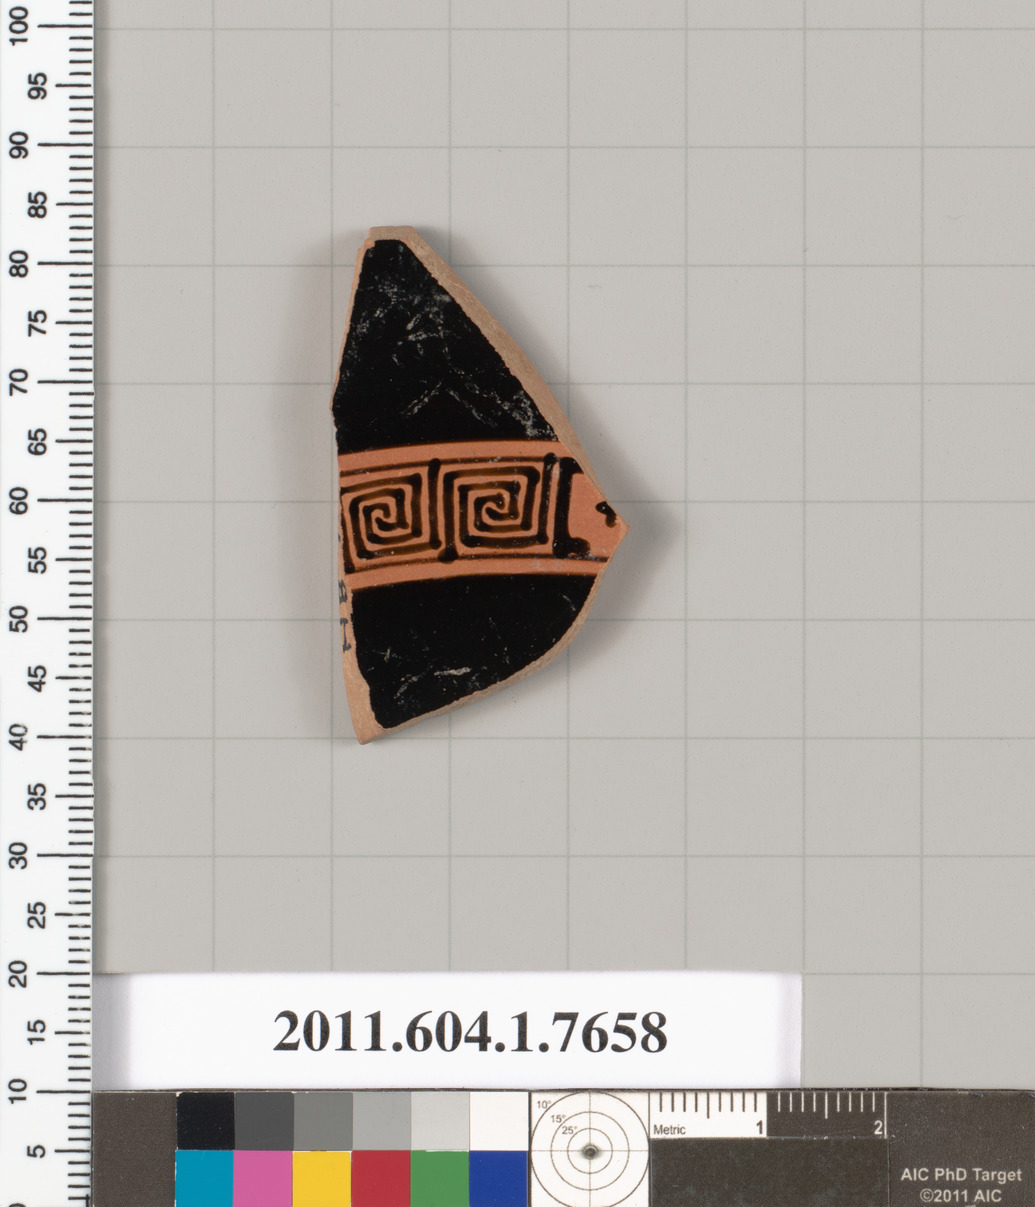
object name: kylix fragment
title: Terracotta fragment of a kylix (drinking cup)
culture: greek, attic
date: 460-450 BCE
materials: terracotta